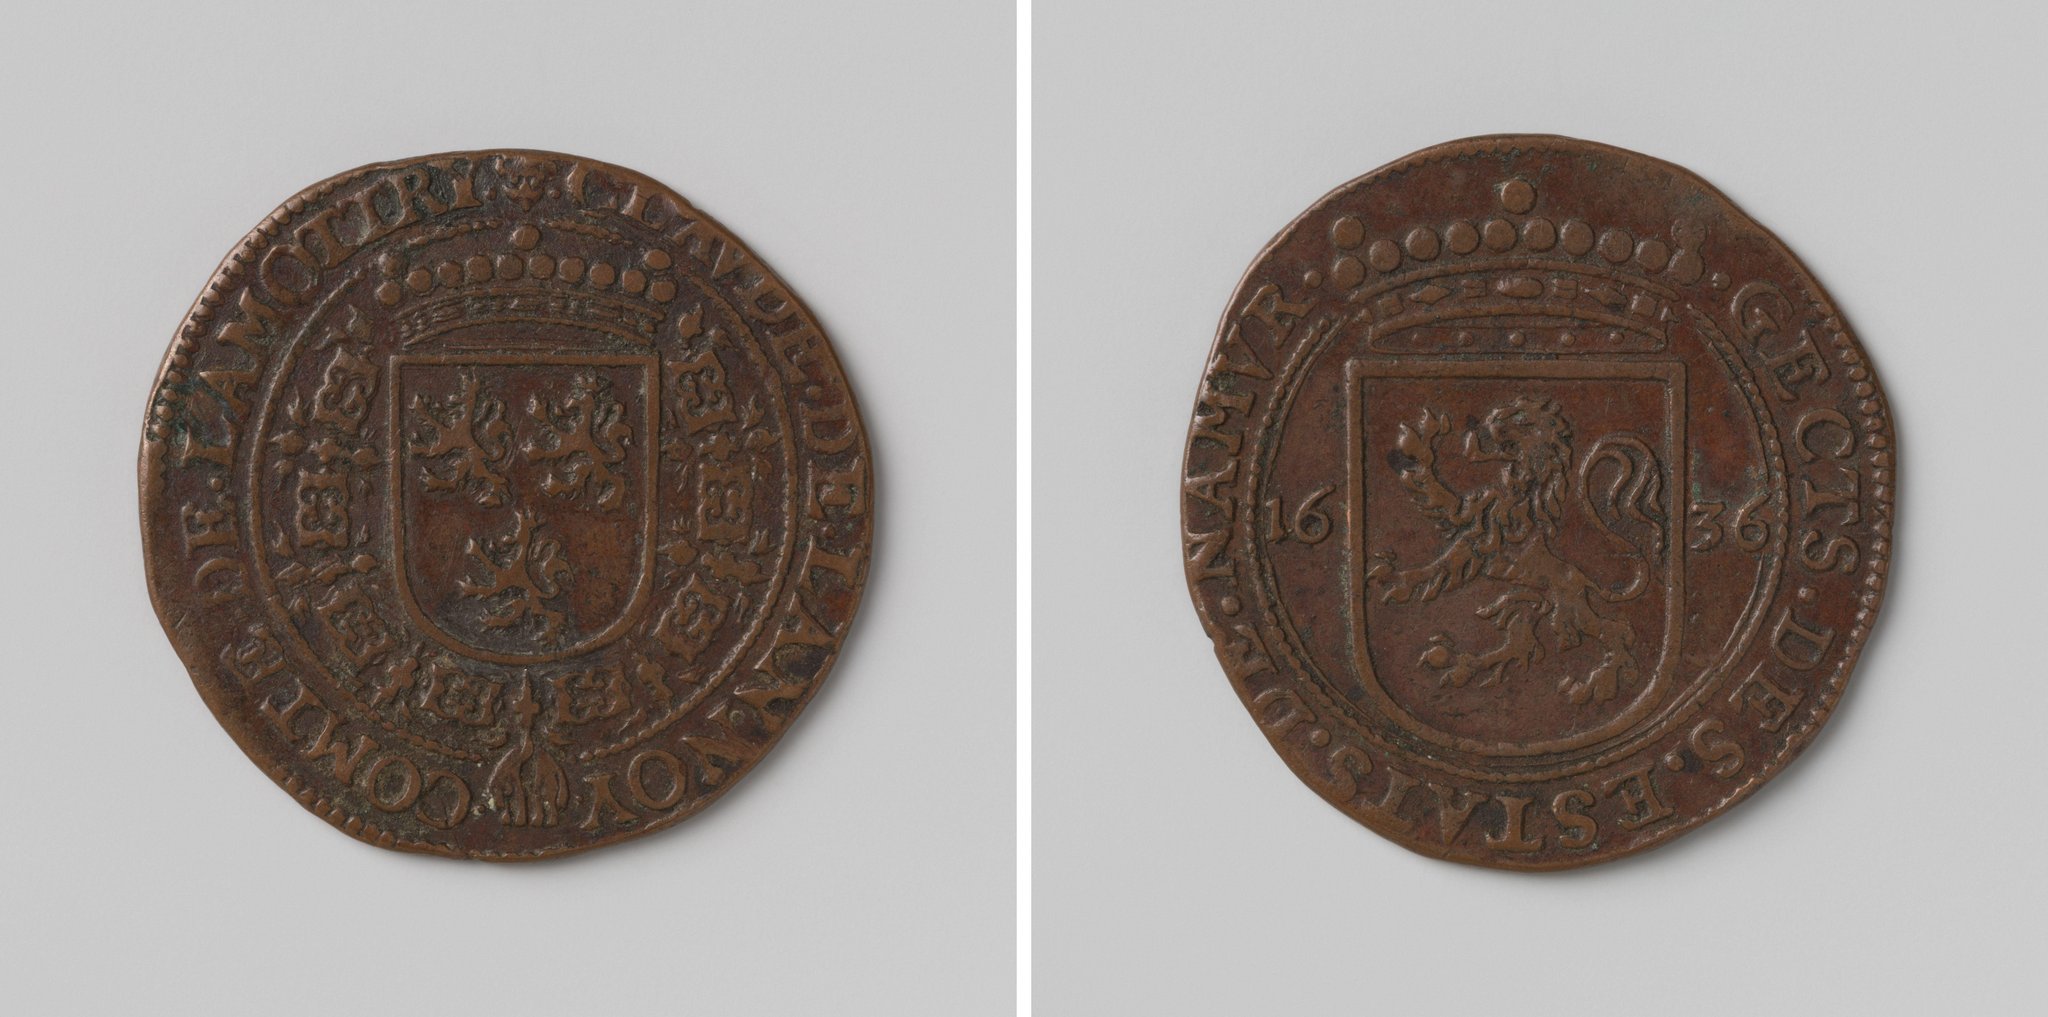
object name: jeton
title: Claude de Lannoy, graaf de La Motterie, landvoogd van de provincie Namen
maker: Anonymous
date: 1636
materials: copper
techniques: striking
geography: brussels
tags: namur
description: Koperen penning. Voorzijde: gekroond wapenschild, omhangen met de orde van het Gulden Vlies binnen omschrift. Keerzijde: gekroond wapenschild tussen jaartal binnen omschrift.